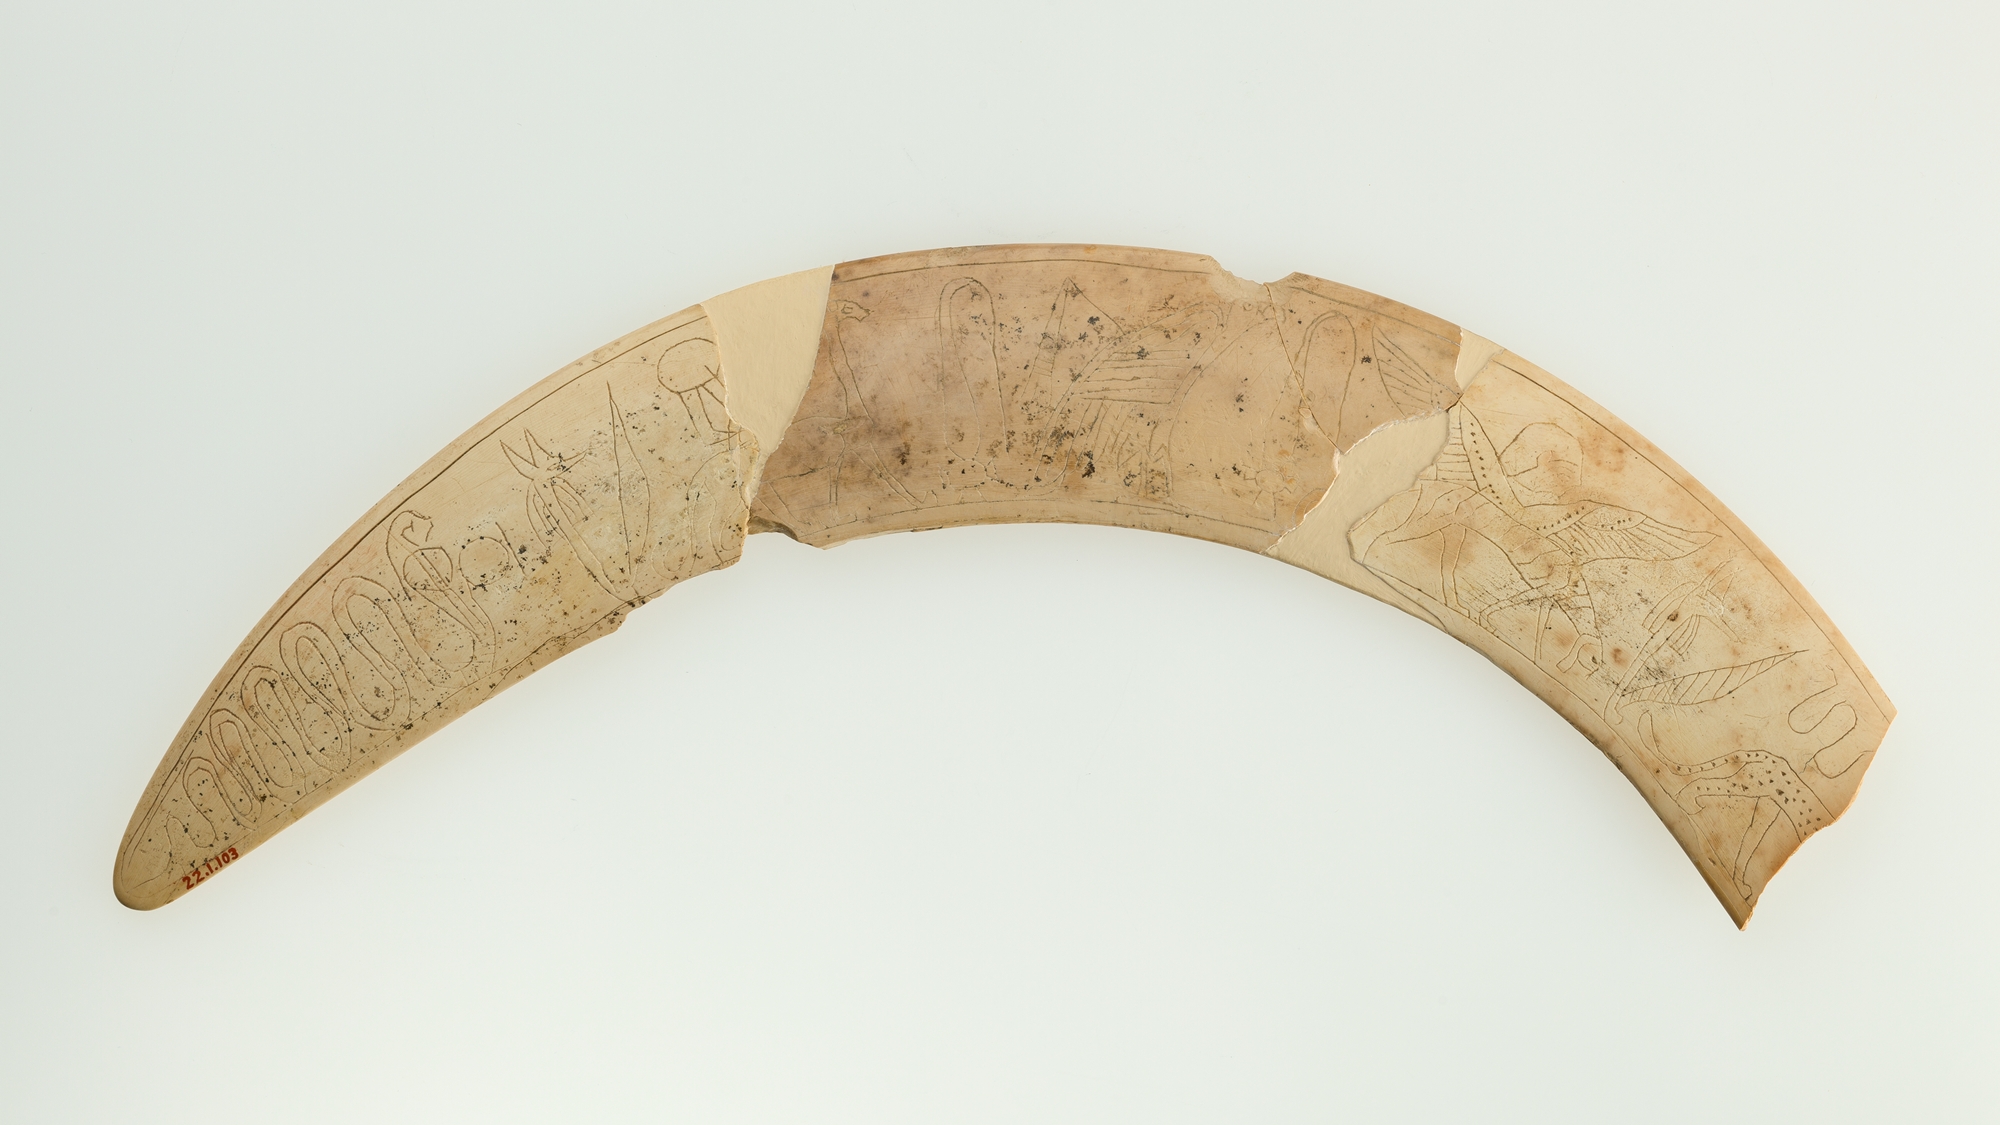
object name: magic wand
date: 1900-1802 BCE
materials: ivory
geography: egypt